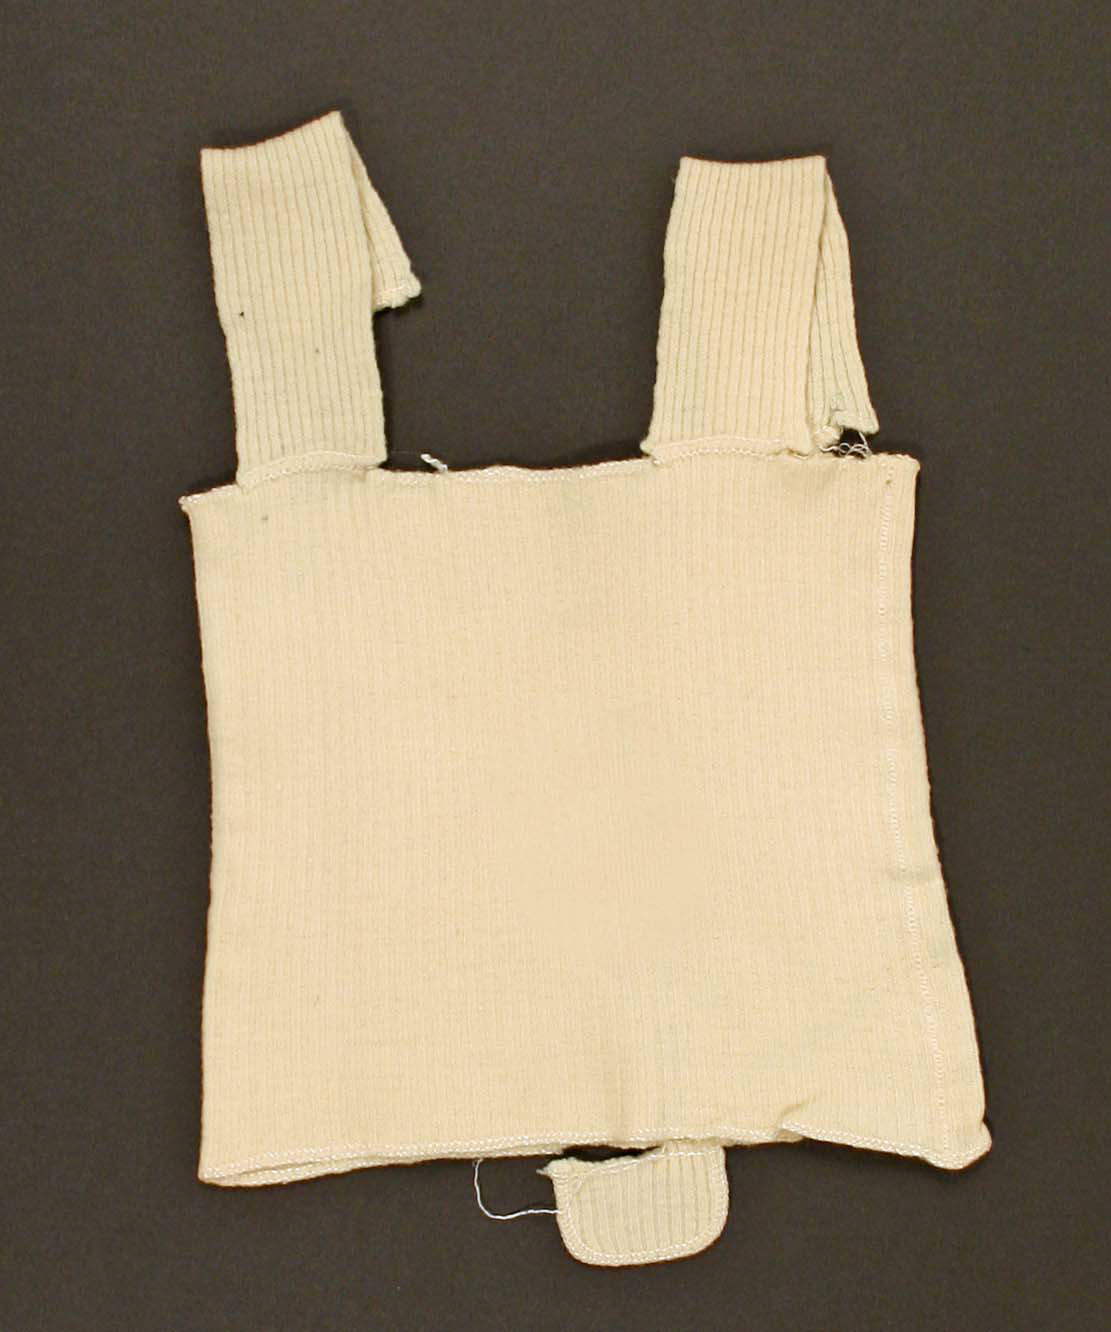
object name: binder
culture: american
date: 1894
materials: wool